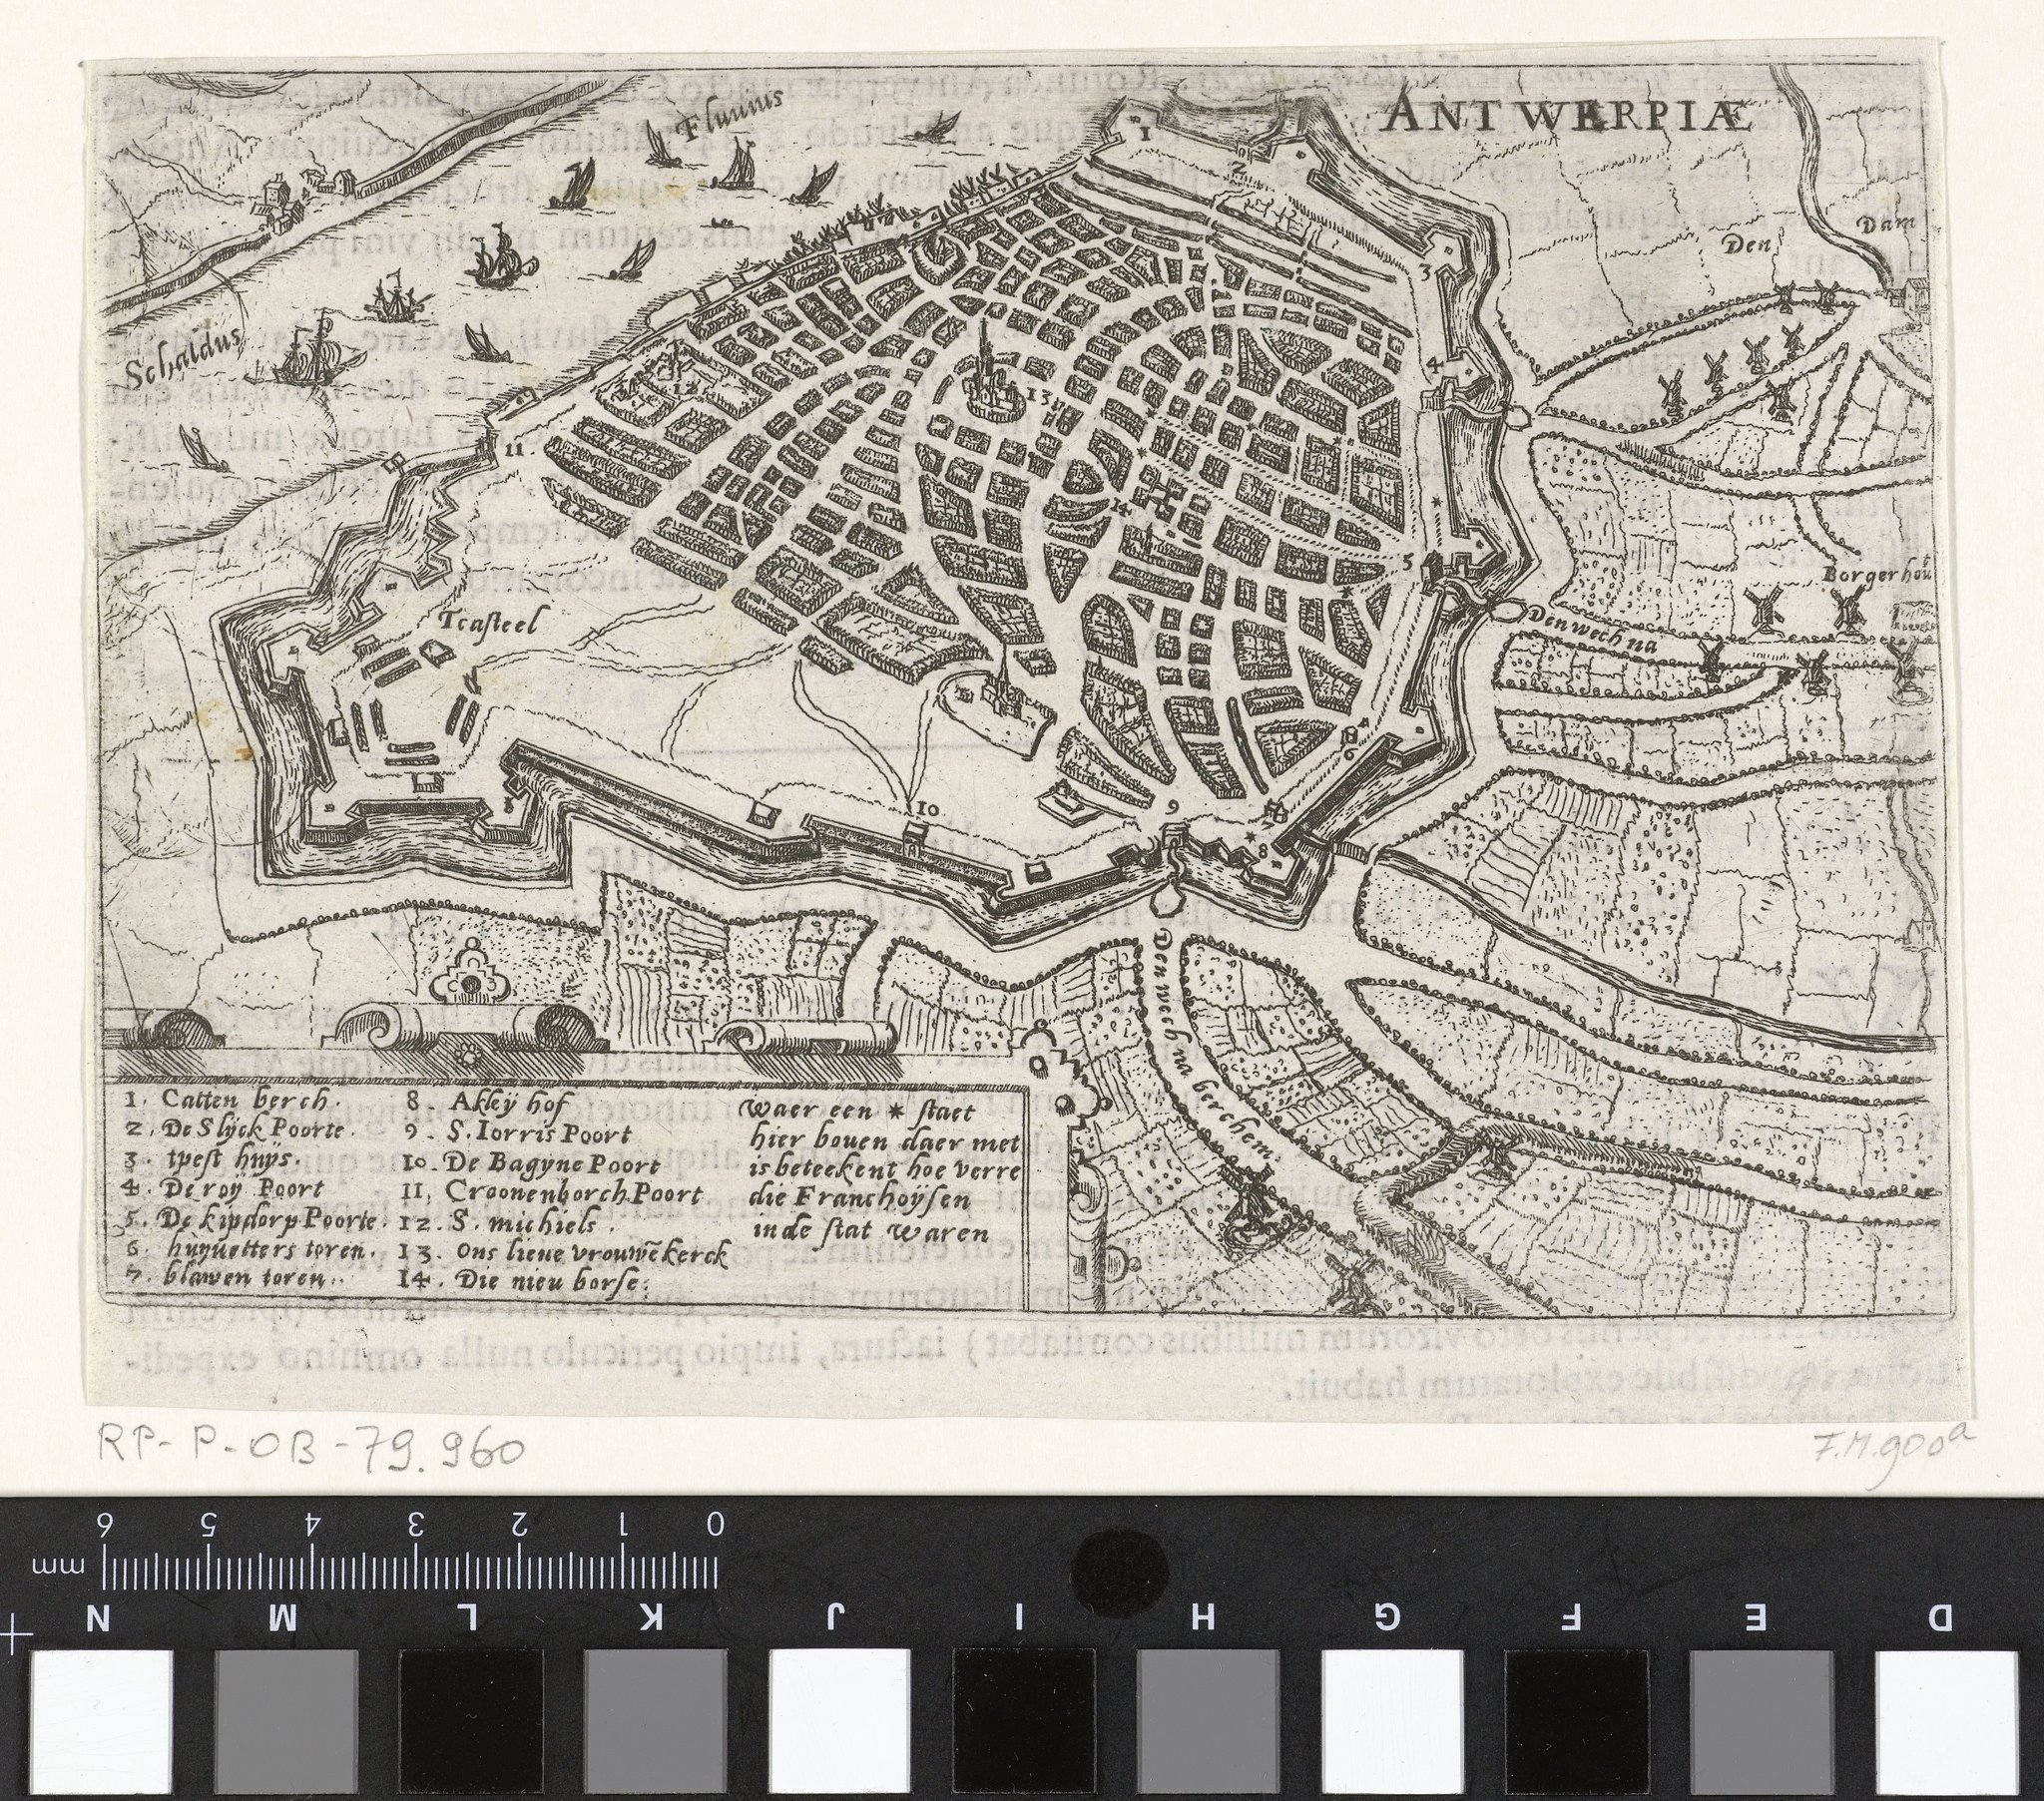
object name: history print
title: Beleg en inname van Antwerpen in 1584/1585: plan van de stad en omgeving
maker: Anonymous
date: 1613-1615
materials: paper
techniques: etching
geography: northern netherlands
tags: maps of cities, antwerp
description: Plan van Antwerpen en het omliggende land. Onderdeel van een groep voorstellingen van het beleg en inname van Antwerpen door de hertog van Parma, juli 1584 tot 17 augustus 1585. Linksonder een cartouche met de legenda 1-14 in het Nederlands. Ongenummerd. Bedrukt op achterzijde met tekst in het Latijn.